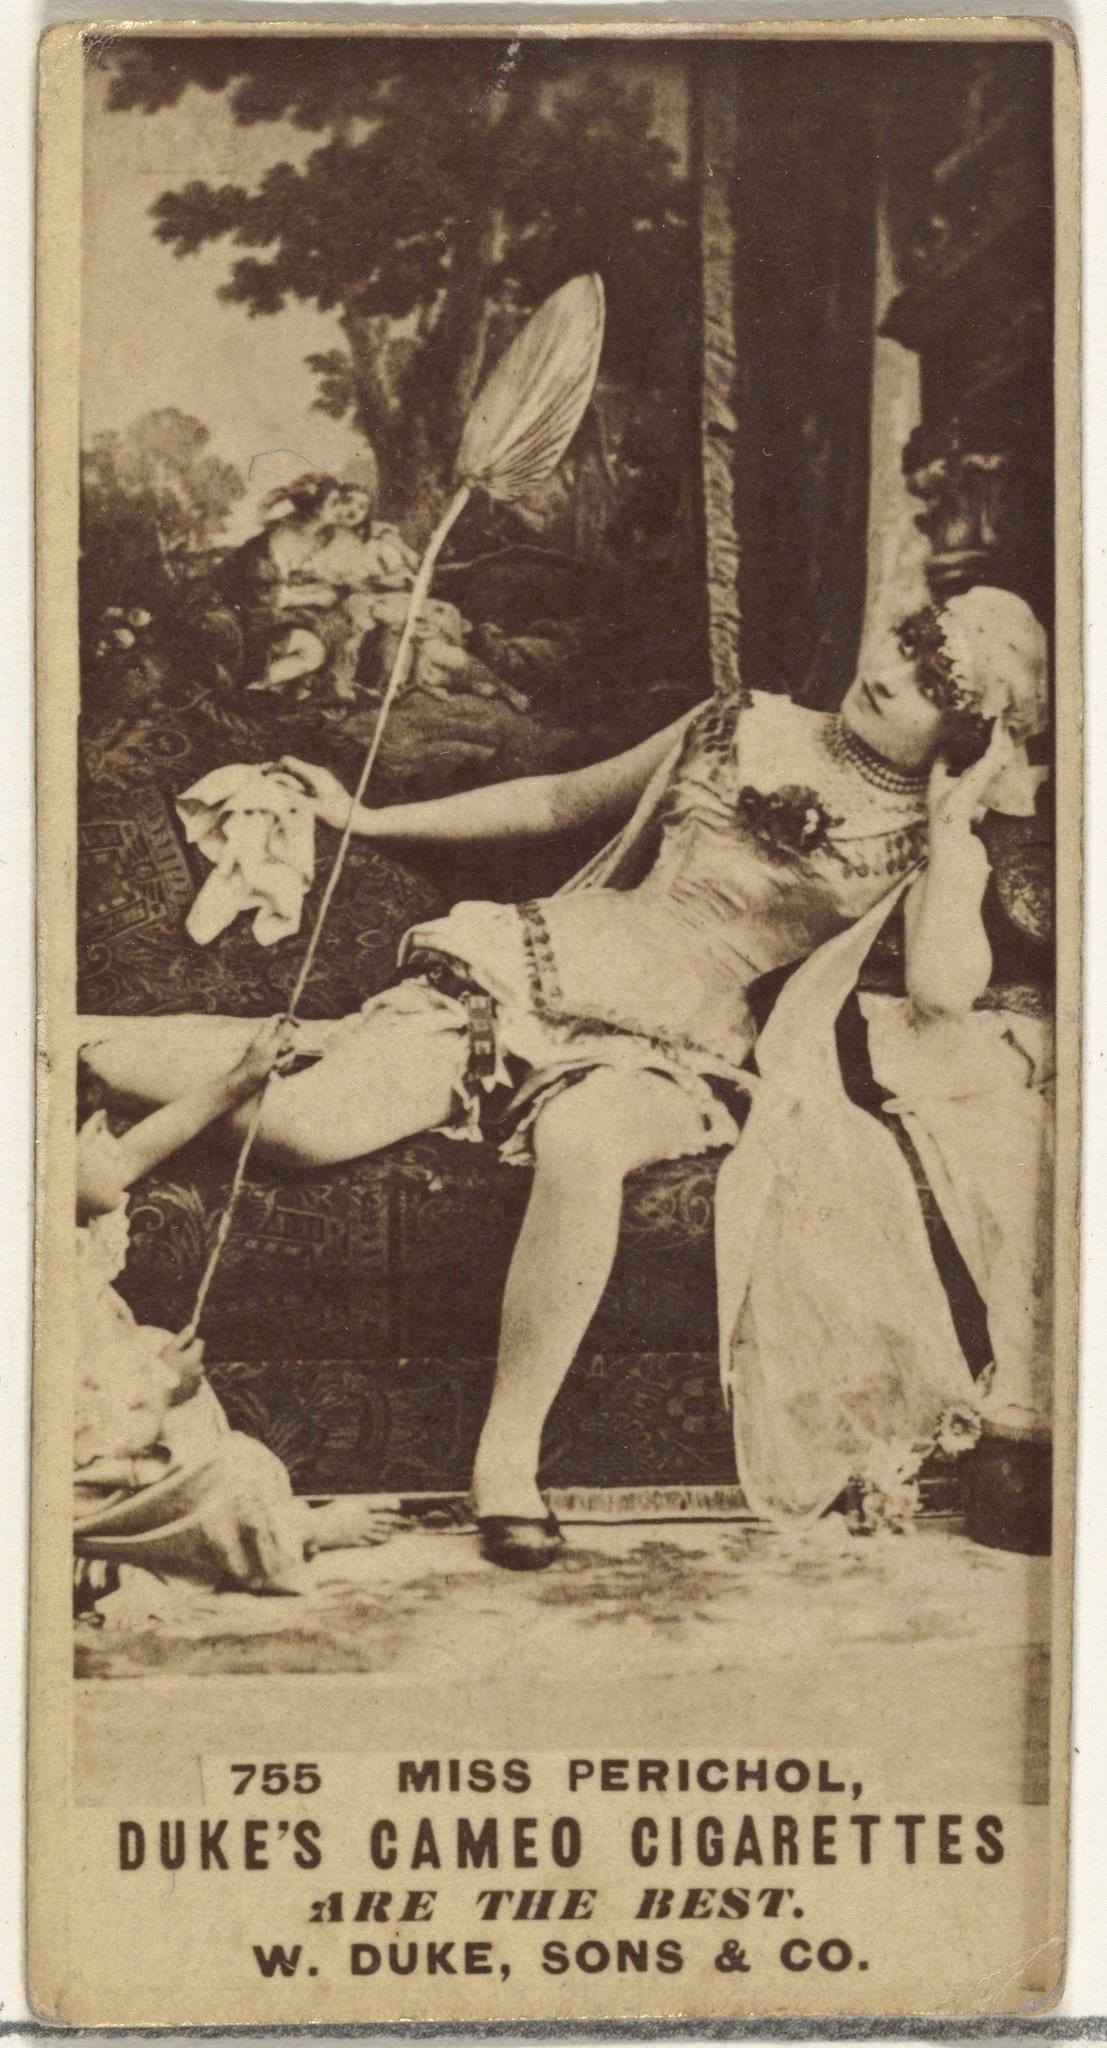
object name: photograph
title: Card Number 755, Miss Perichol, from the Actors and Actresses series (N145-5) issued by Duke Sons & Co. to promote Cameo Cigarettes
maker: w. duke, sons & co.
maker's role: publisher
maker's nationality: american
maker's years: 1870-1920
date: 1880-1889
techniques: albumen silver print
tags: portraits,women,actresses